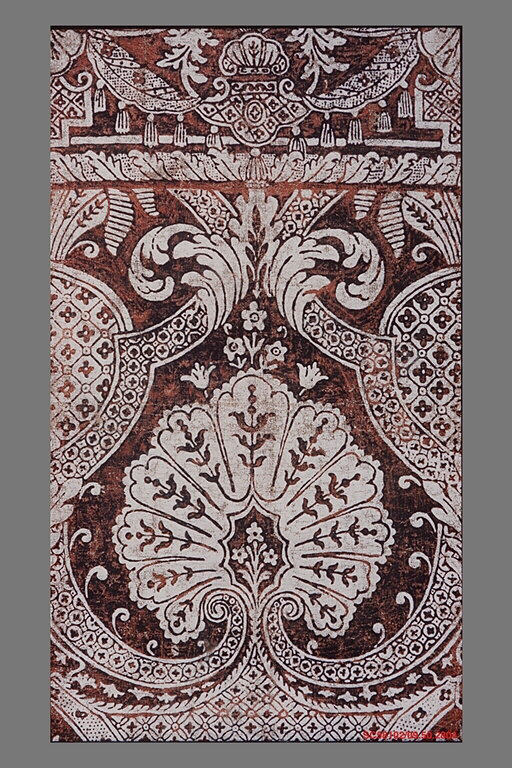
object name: hanging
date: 1667-1733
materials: canvas